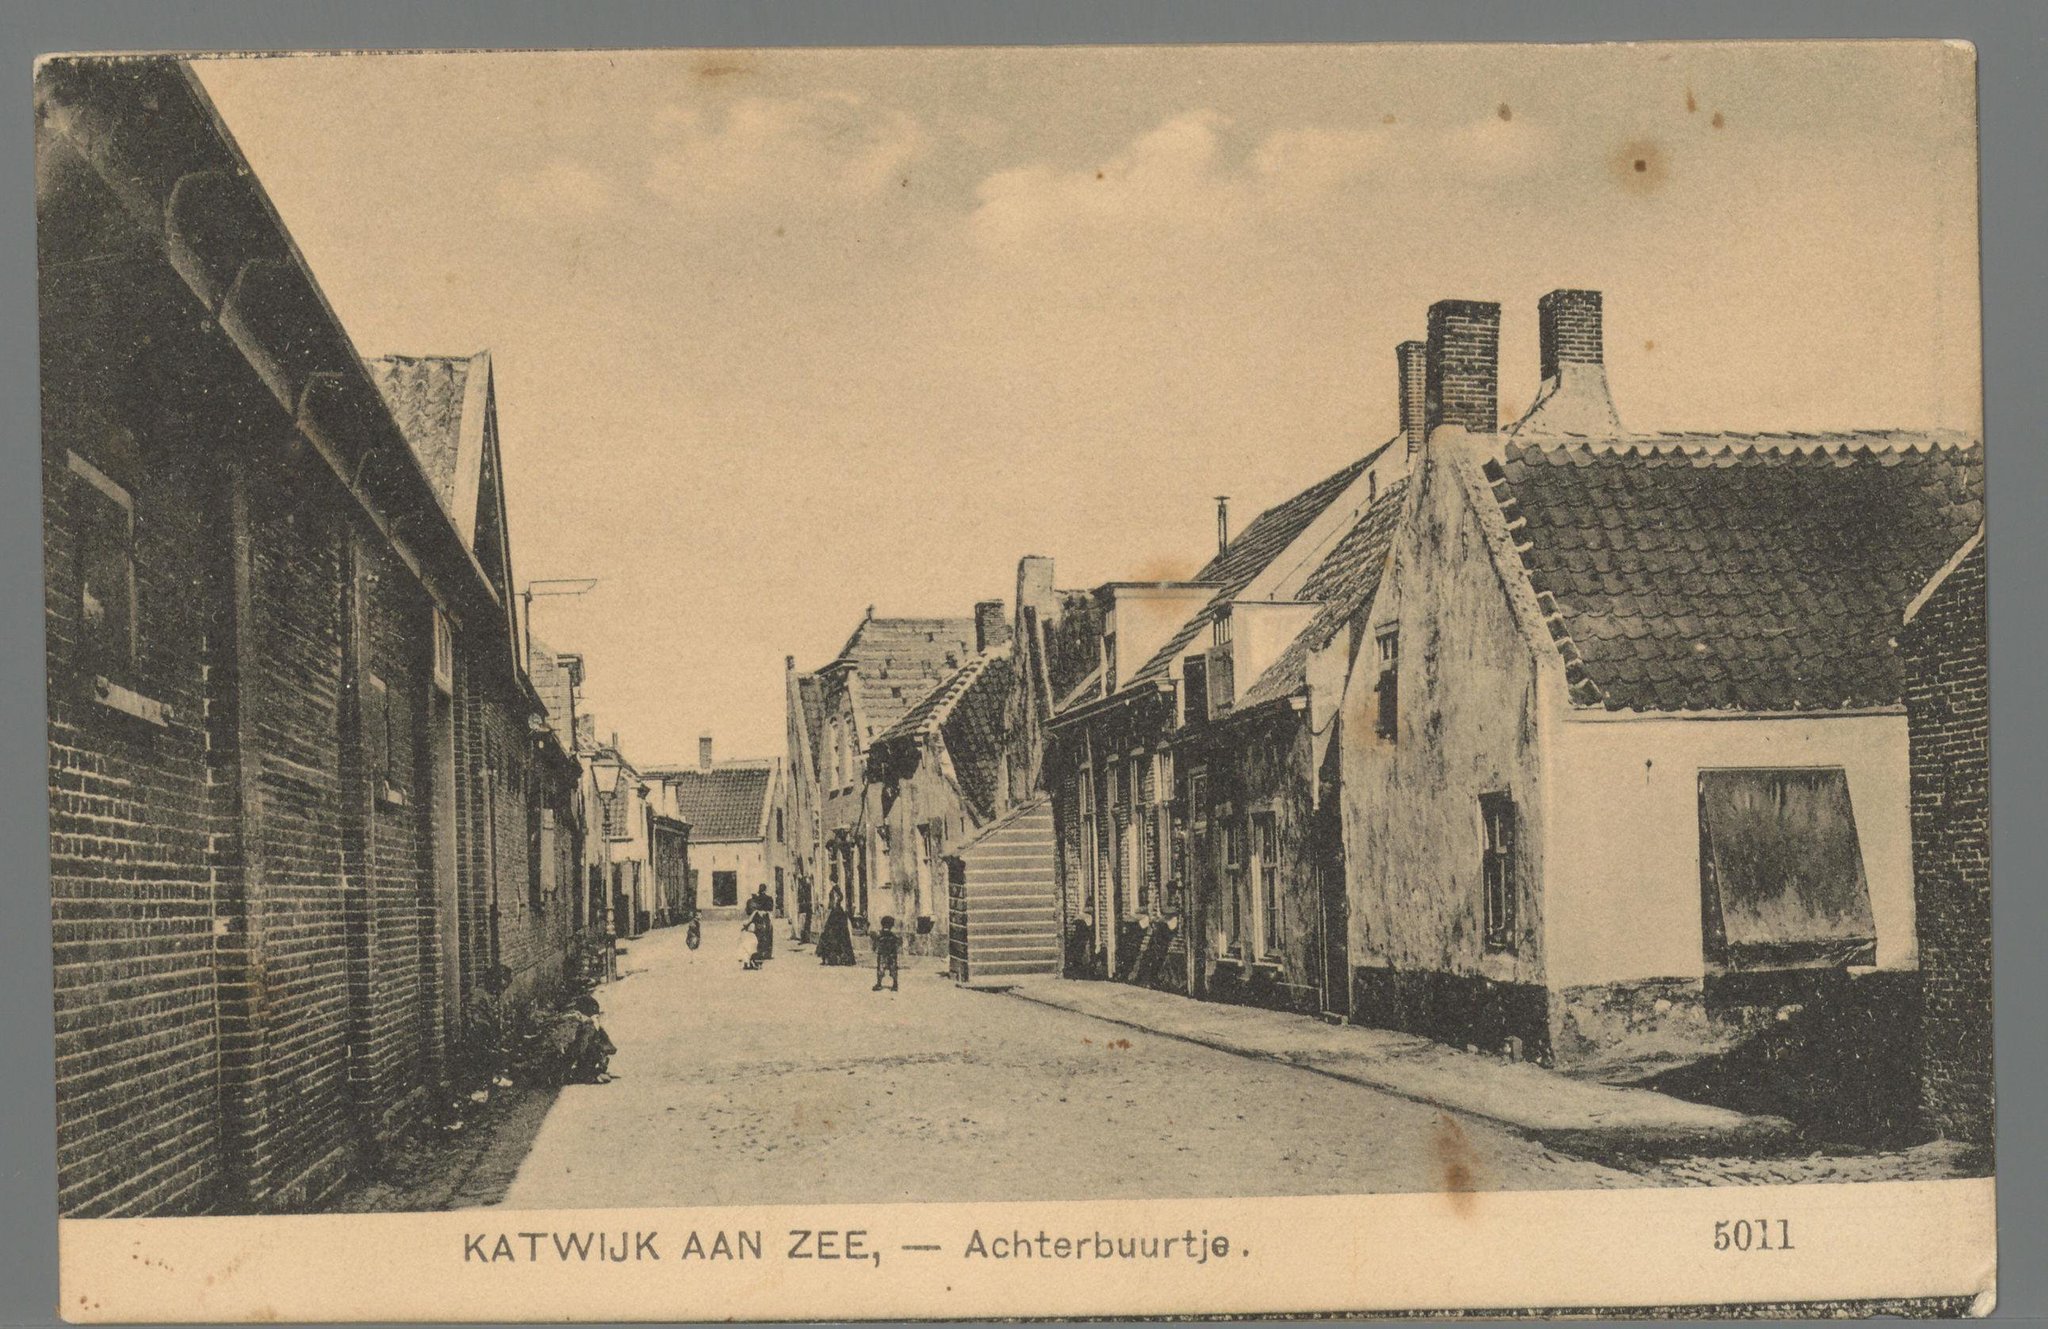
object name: ansichtkaart, prentbriefkaart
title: Katwijk aan Zee, - Achterbuurtje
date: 1905-1927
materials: cardboard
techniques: photograph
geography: katwijk aan zee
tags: street